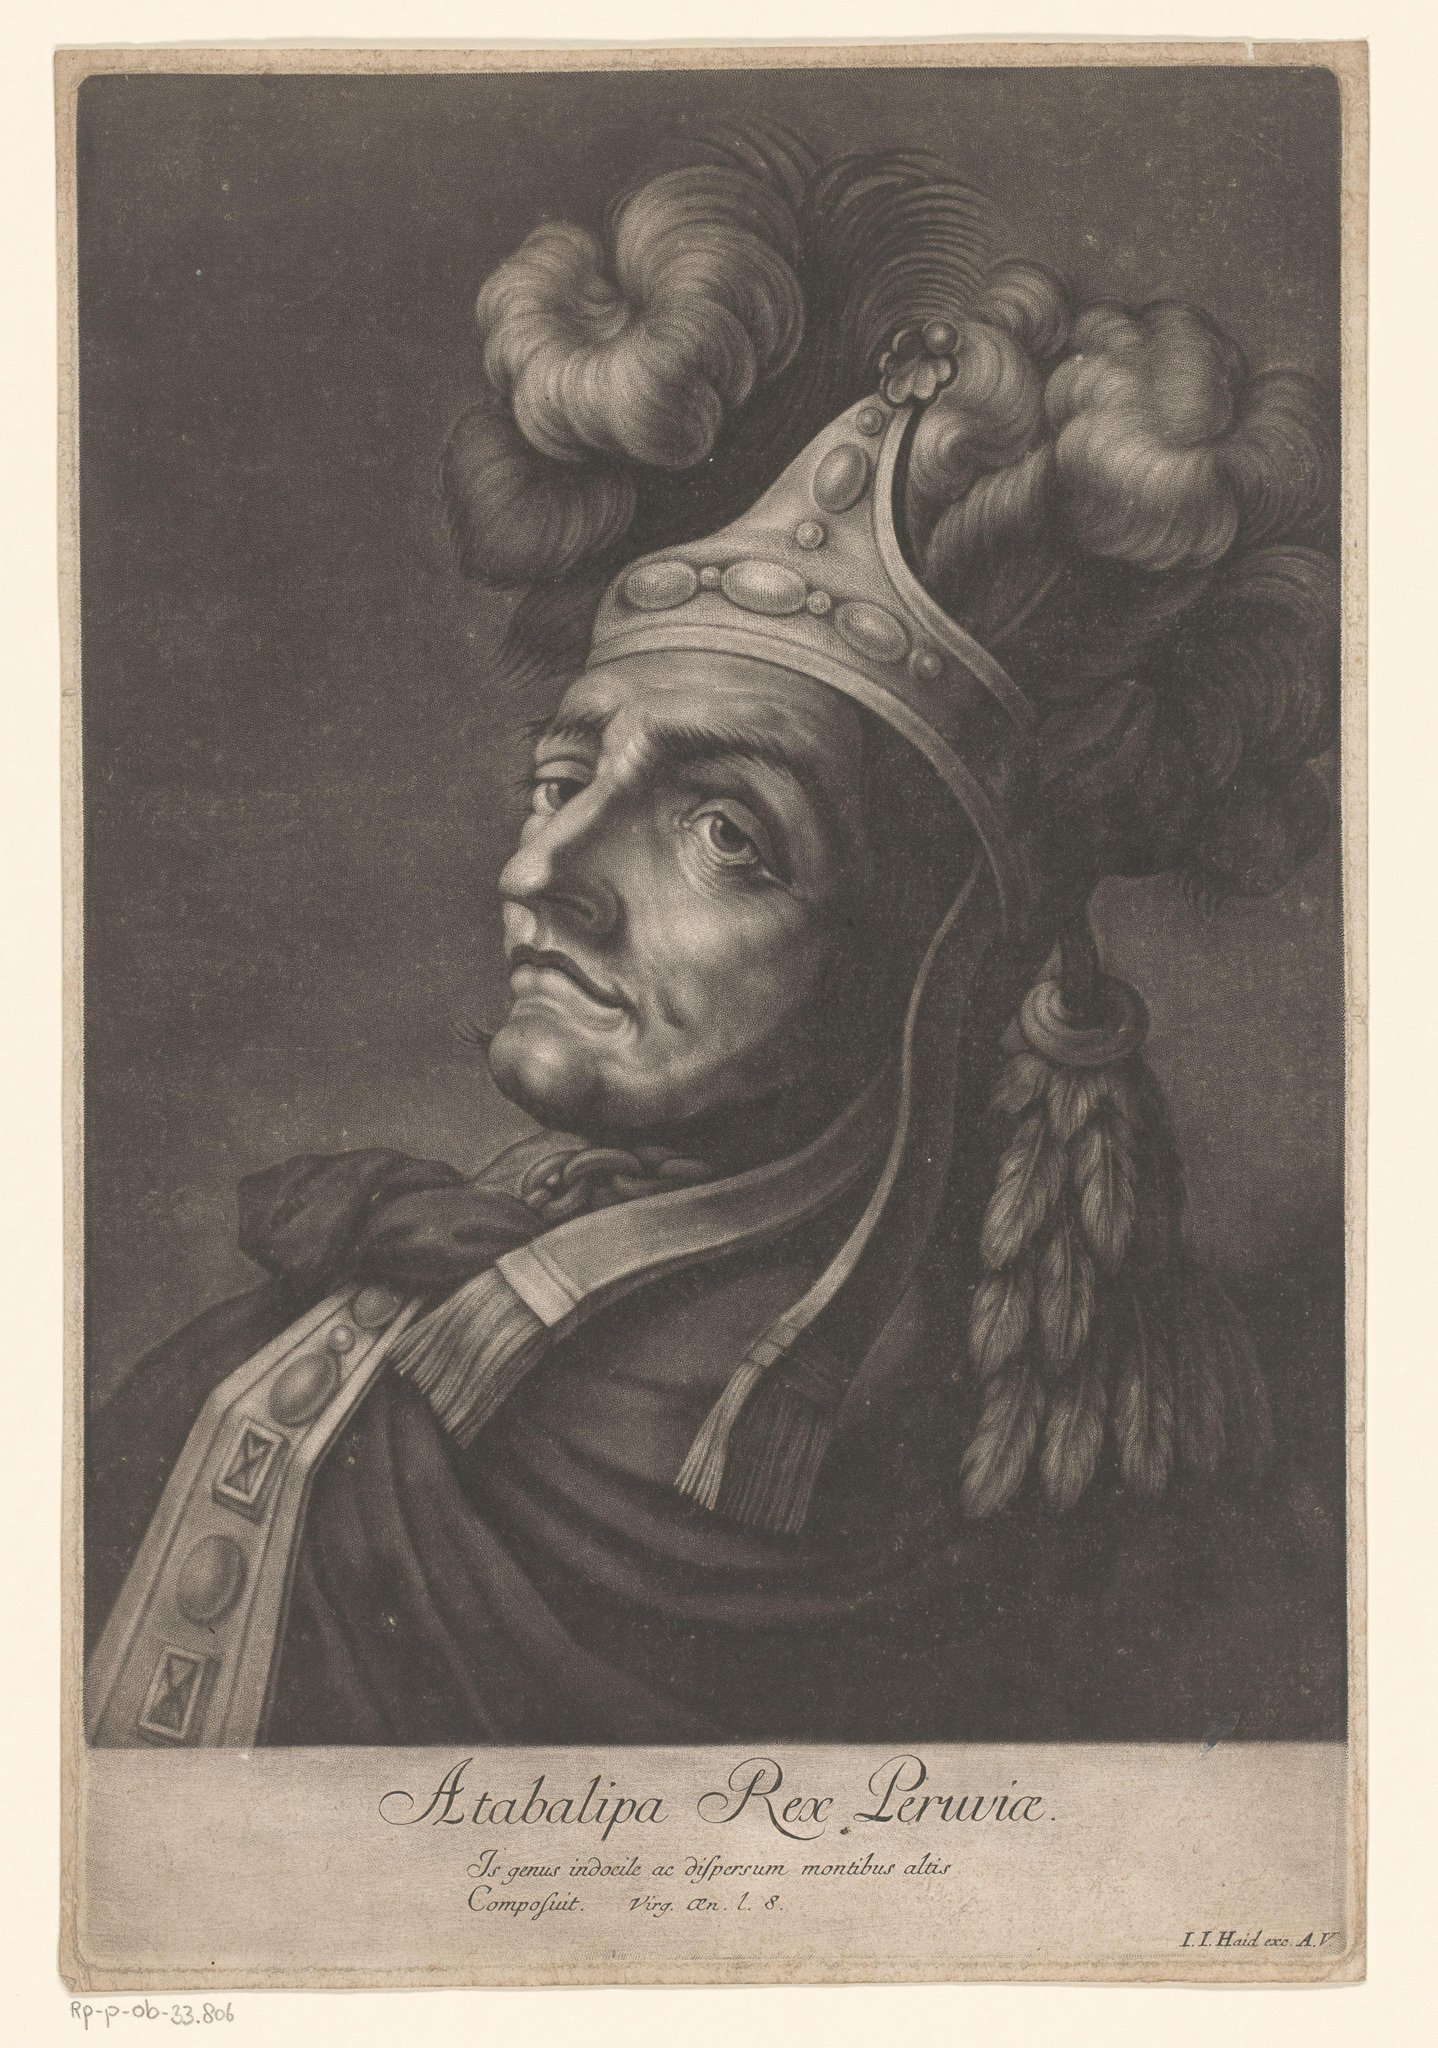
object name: print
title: Atabalipa Rex Peruviae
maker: johann jacob haid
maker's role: print maker, publisher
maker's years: 1704-1767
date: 1714-1767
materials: paper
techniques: mezzotint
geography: augsburg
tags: crown (symbol of sovereignty), historical persons, ruler, sovereign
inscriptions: collector's mark: Lugt 2228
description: Met onderschrift uit de Aeneas van Vergilius.